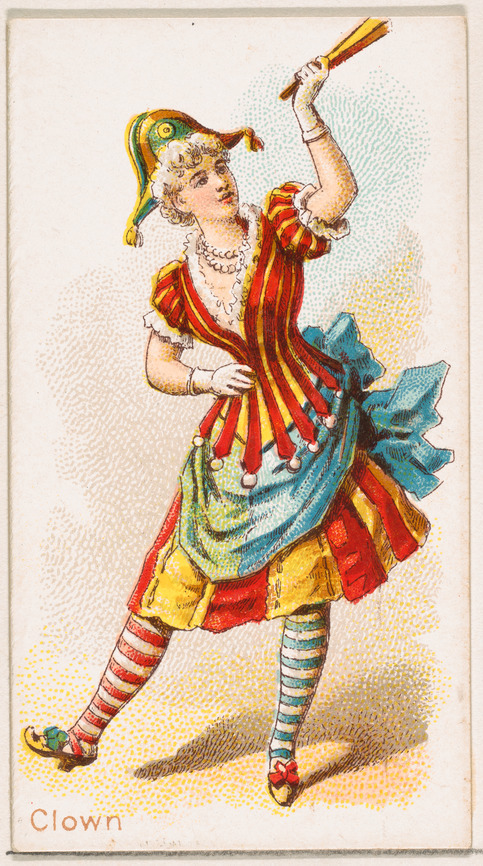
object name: print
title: Clown Dancer, from the Dancing Women series (N186) issued by Wm. S. Kimball & Co.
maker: william s. kimball & company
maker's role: publisher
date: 1889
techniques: color lithograph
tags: women,dancers